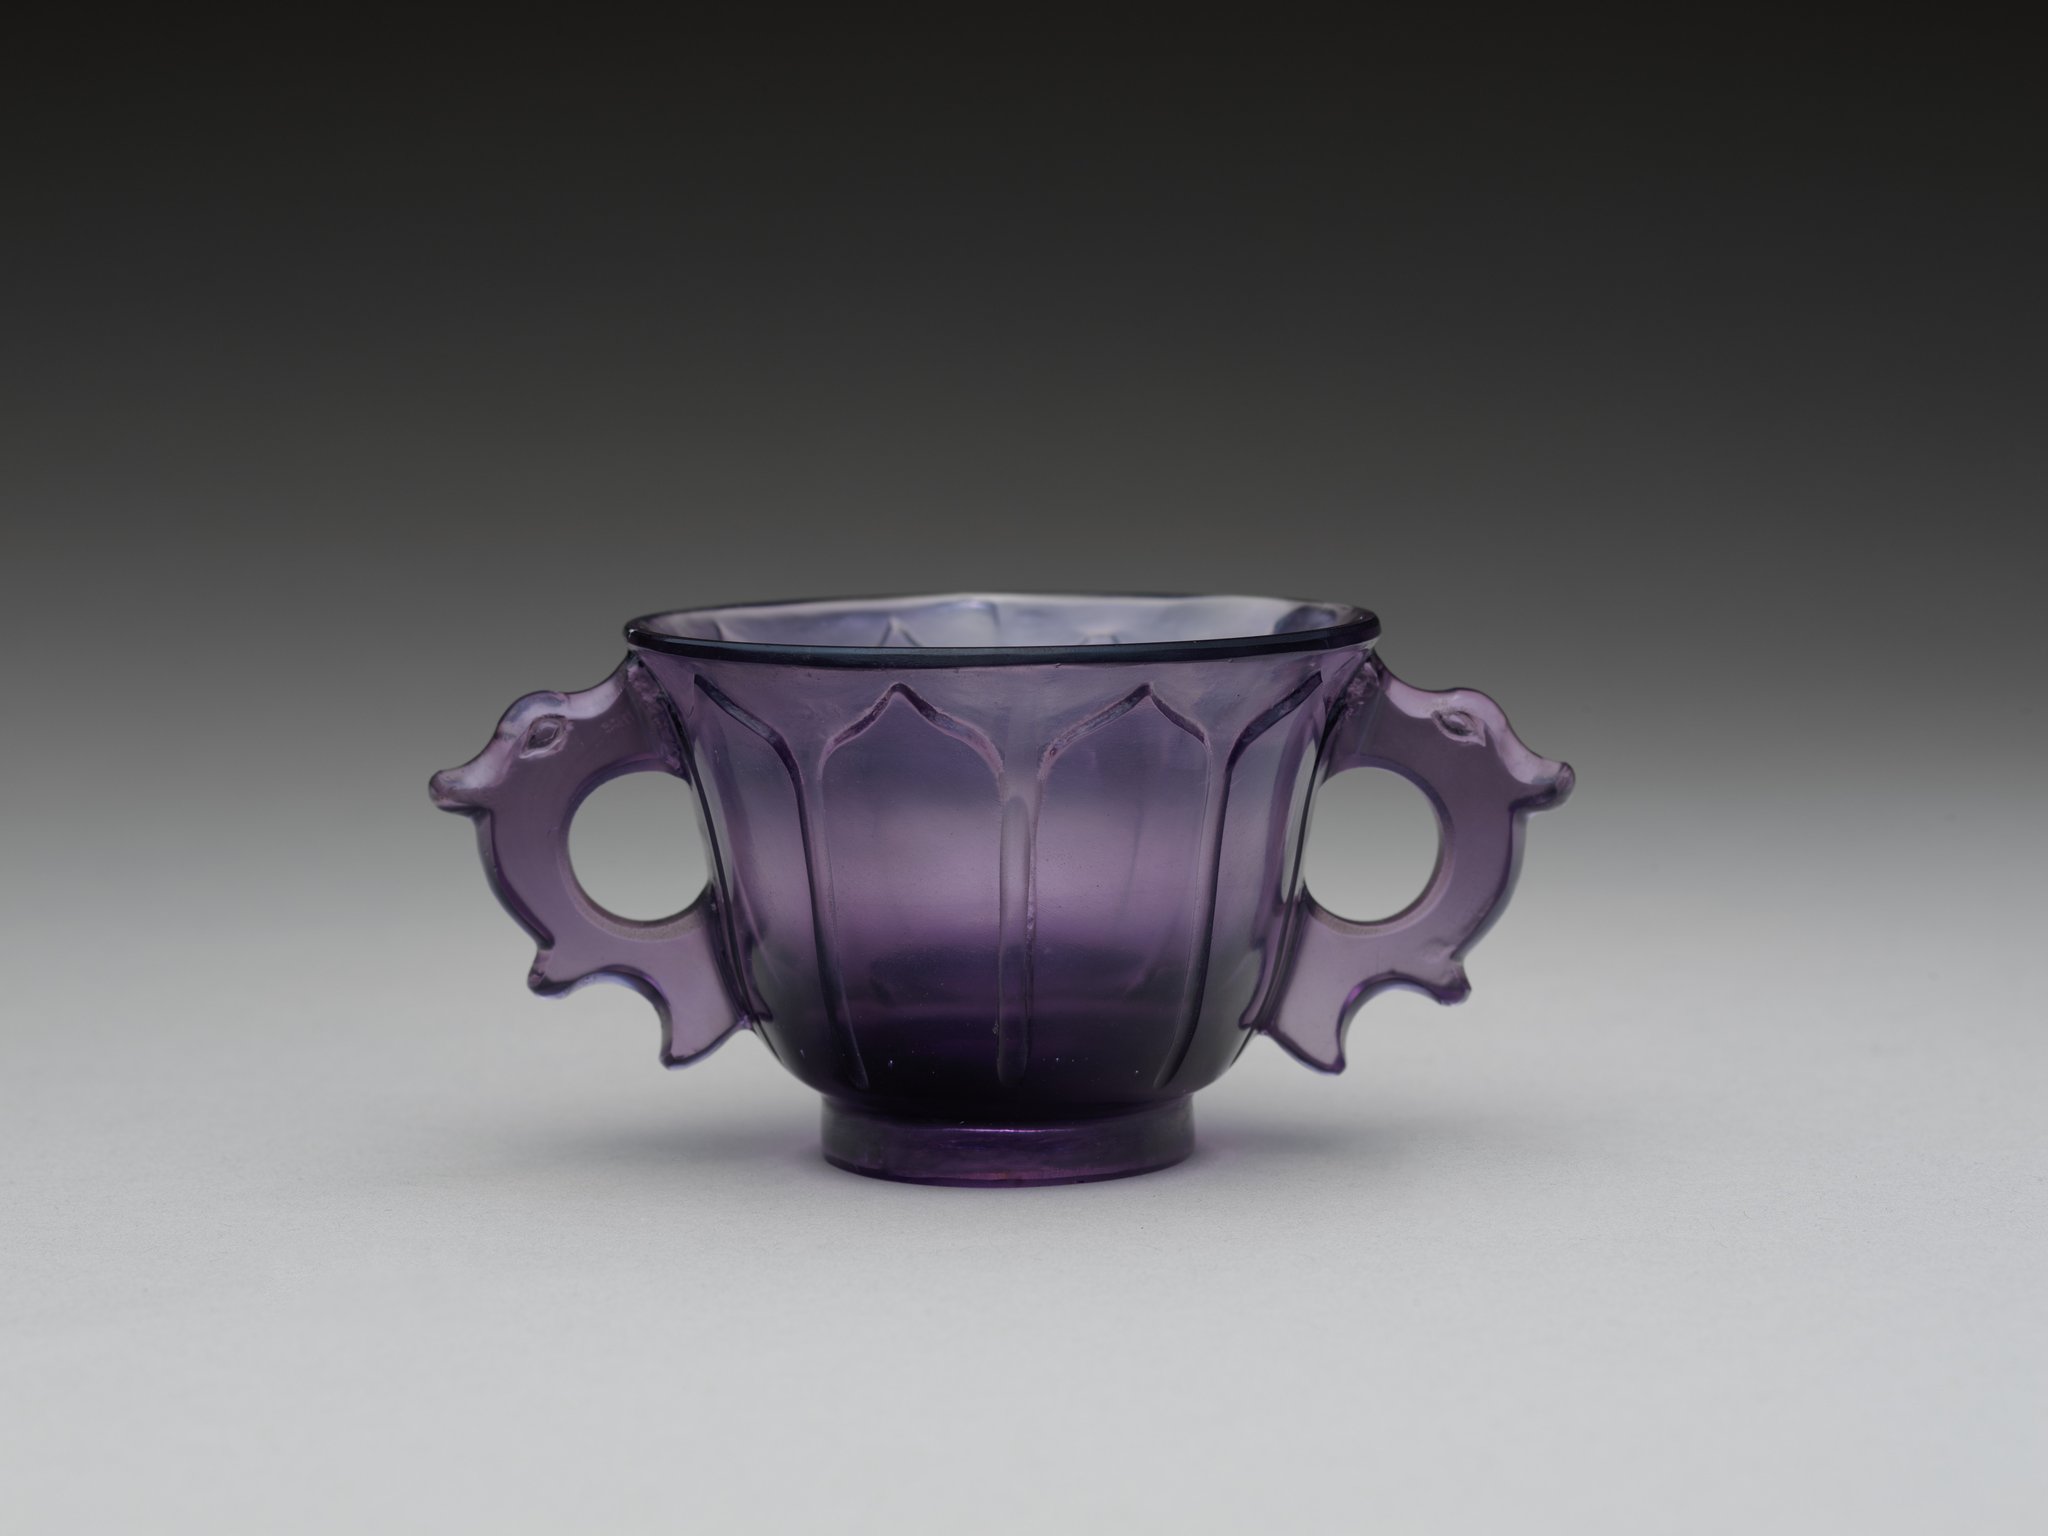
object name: cup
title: Cup with Dragon-Shaped Handles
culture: chinese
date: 1701-1900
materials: glass